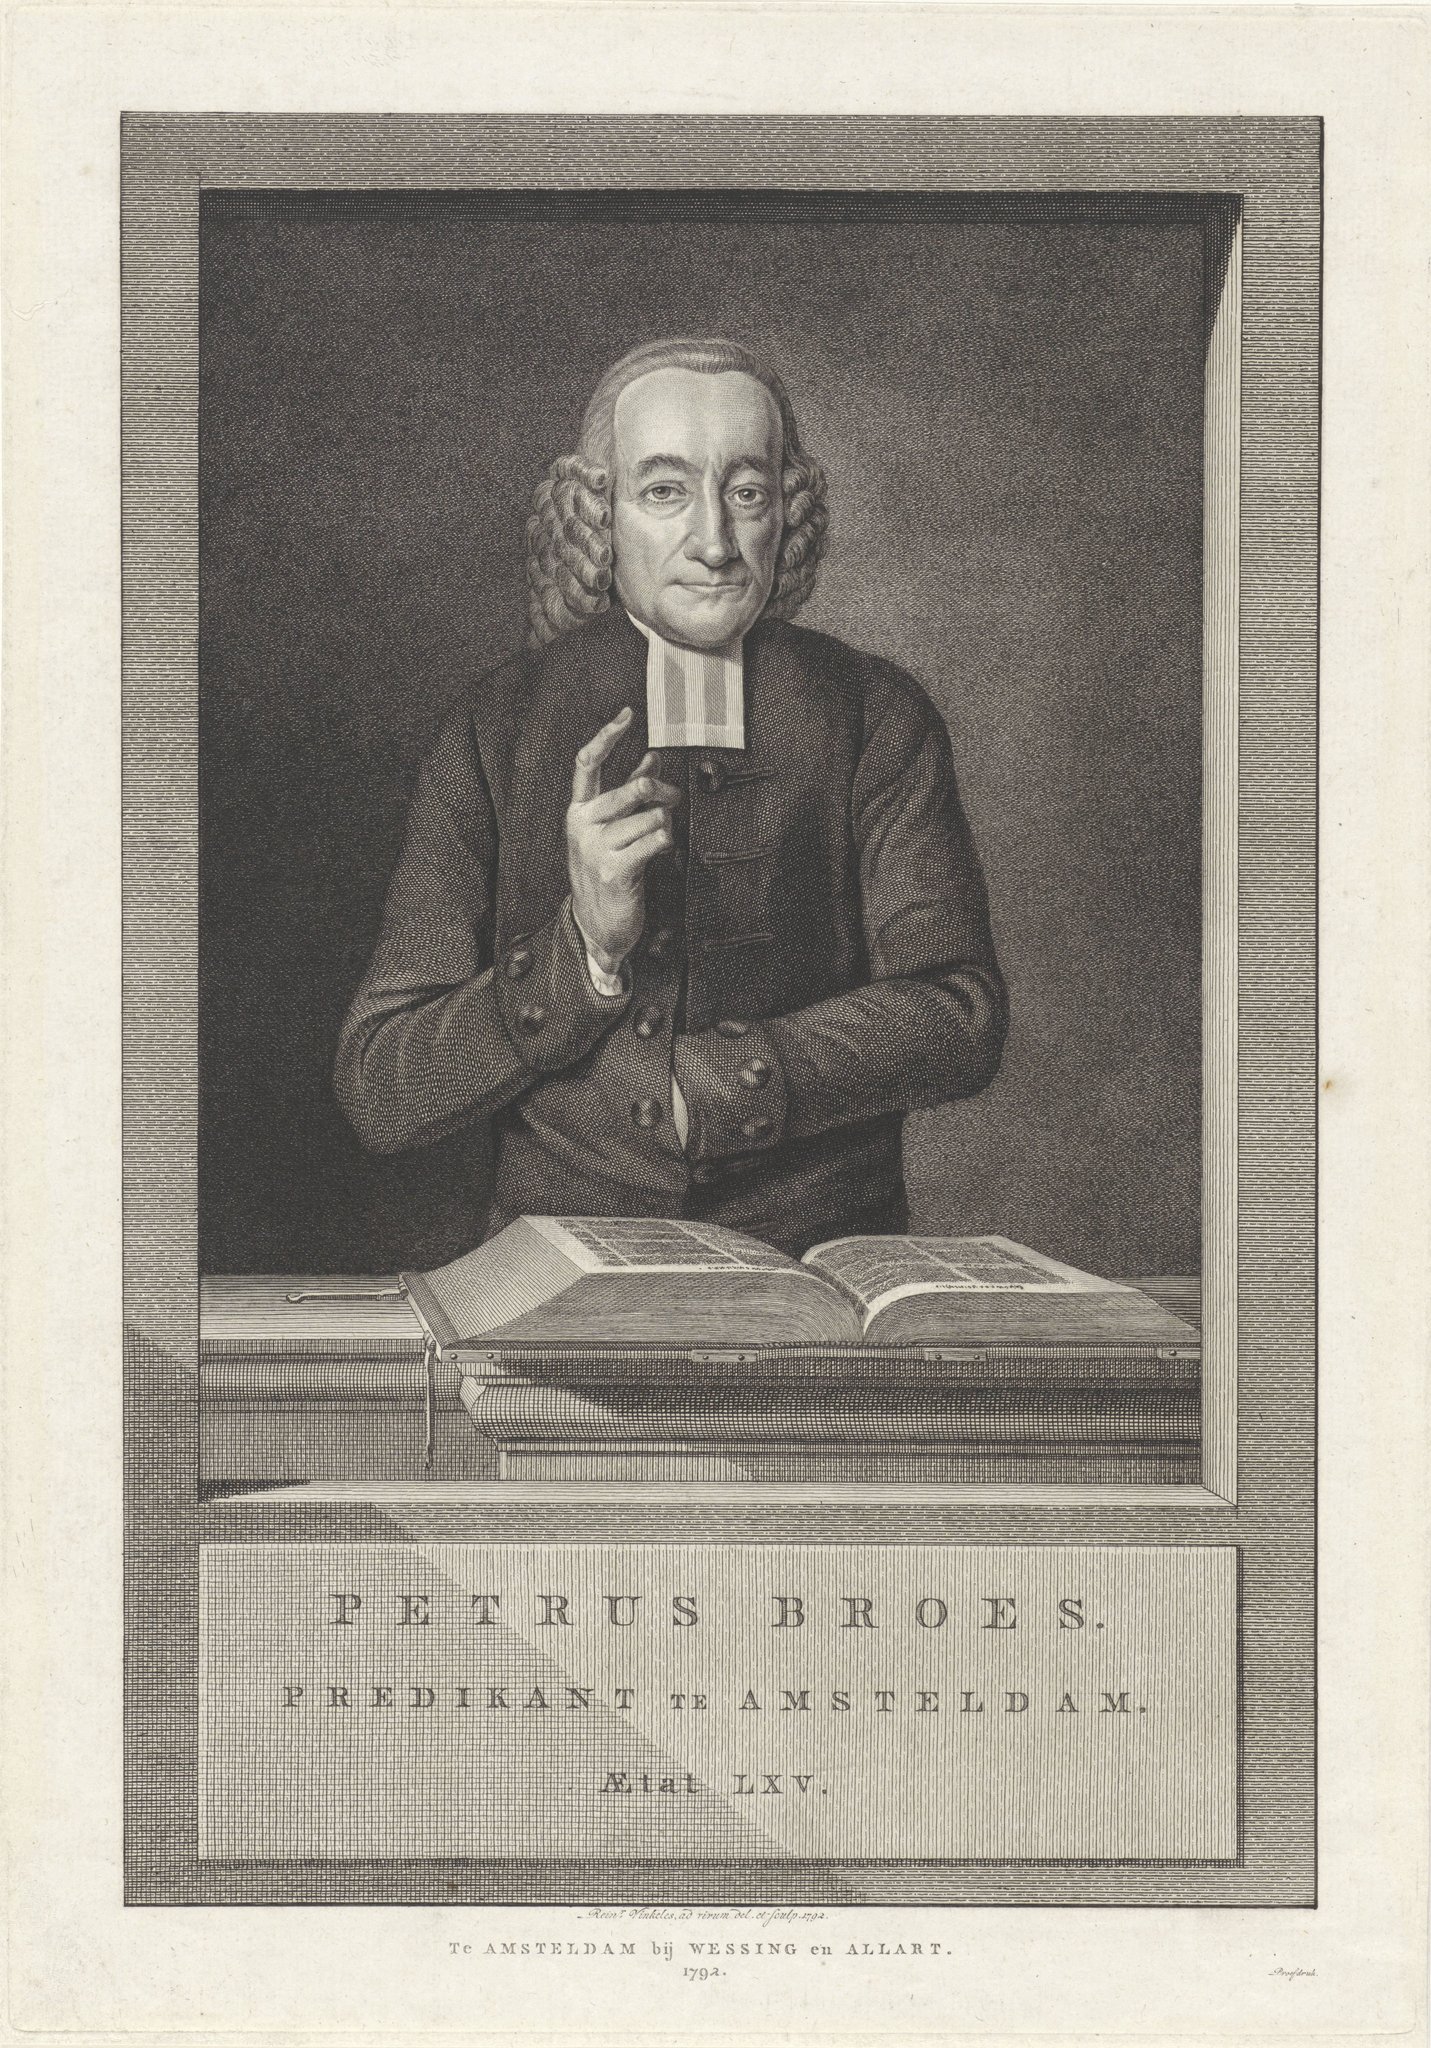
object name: print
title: Portret van Petrus Broes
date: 1792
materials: paper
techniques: engraving, etching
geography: amsterdam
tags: amsterdam, the bible as a book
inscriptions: collector's mark: Lugt 2228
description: Portret van Petrus Broes, predikant te Amsterdam, predikend met voor zich een opengeslagen bijbel.